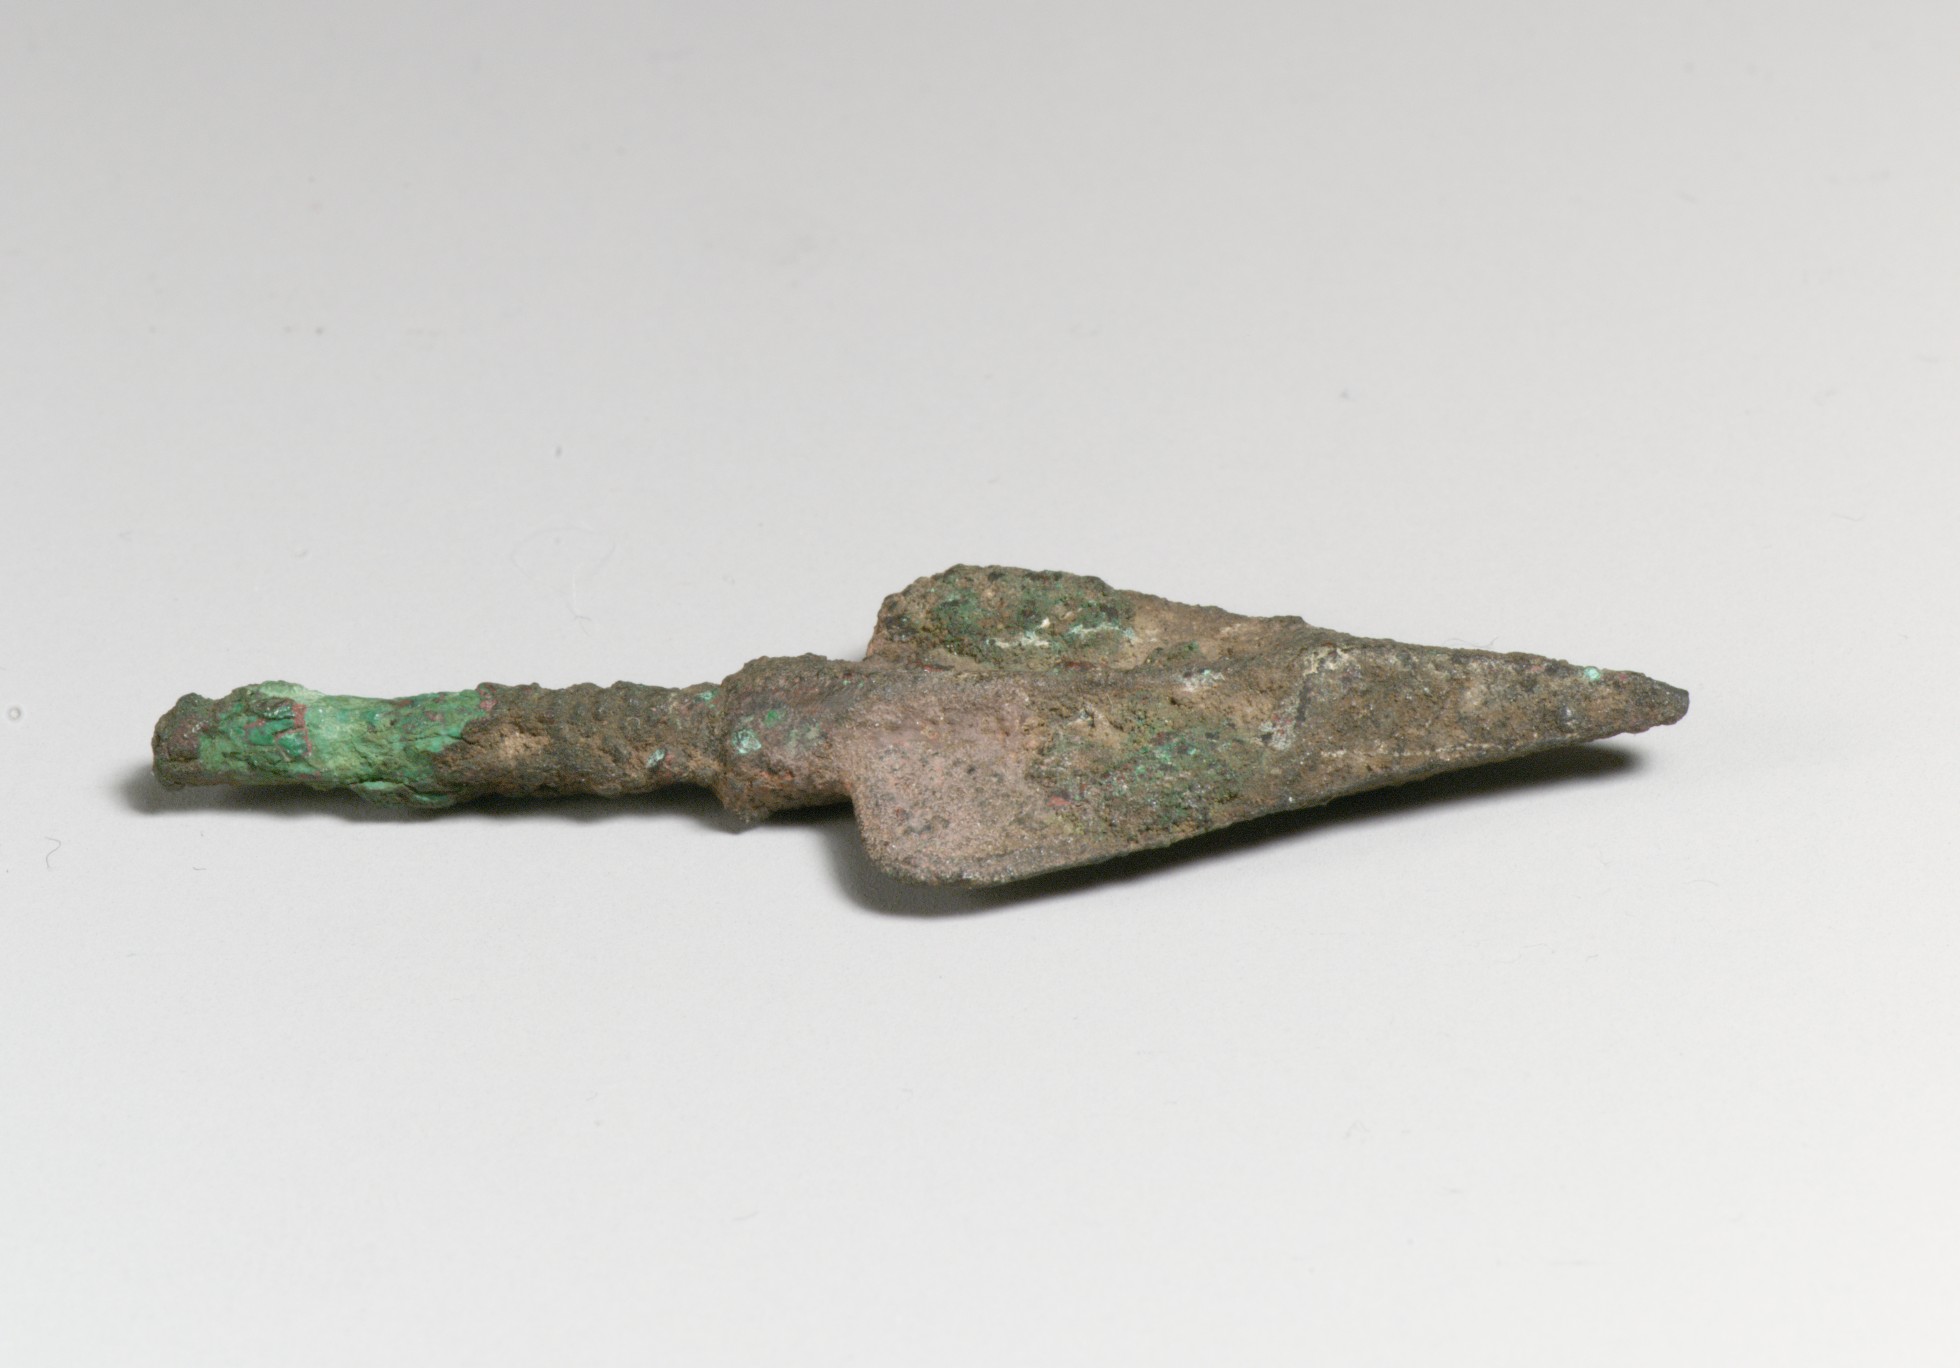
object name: arrowhead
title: Bronze arrowhead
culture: cypriot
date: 1600-1050 BCE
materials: bronze